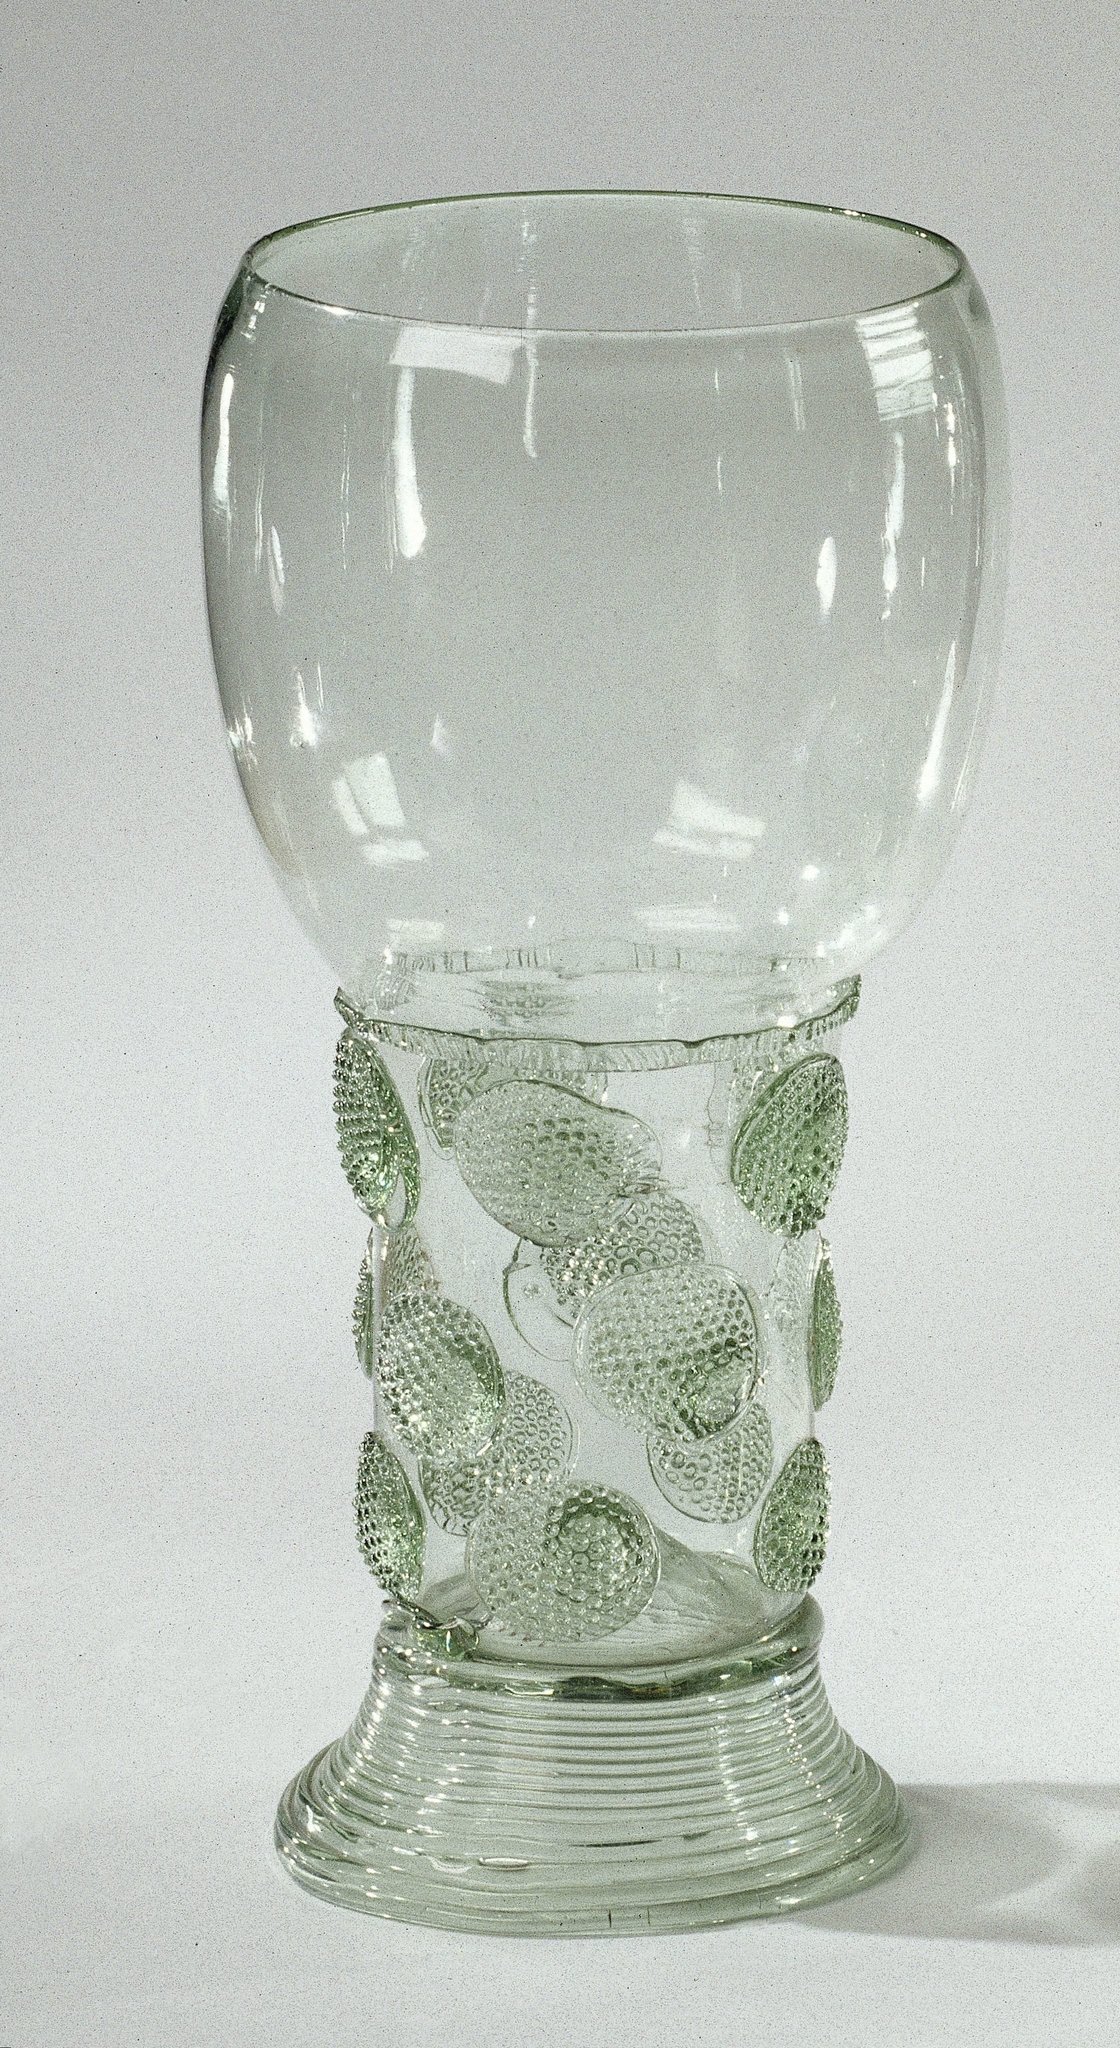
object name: roemer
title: Rummer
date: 1650-1675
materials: glass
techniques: glassblowing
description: Grote roemer, lichtgroen, met concave, uit een draad gesponnen voet. Ingestoken bodem. De hoge, eivormige kelk als één geheel geblazen met de stam, die bezet is met drie rijen grote platte braamnoppen, gestempeld in een fijn patroon. De overgang van de kelk naar de stam aangegeven door een geribde draad